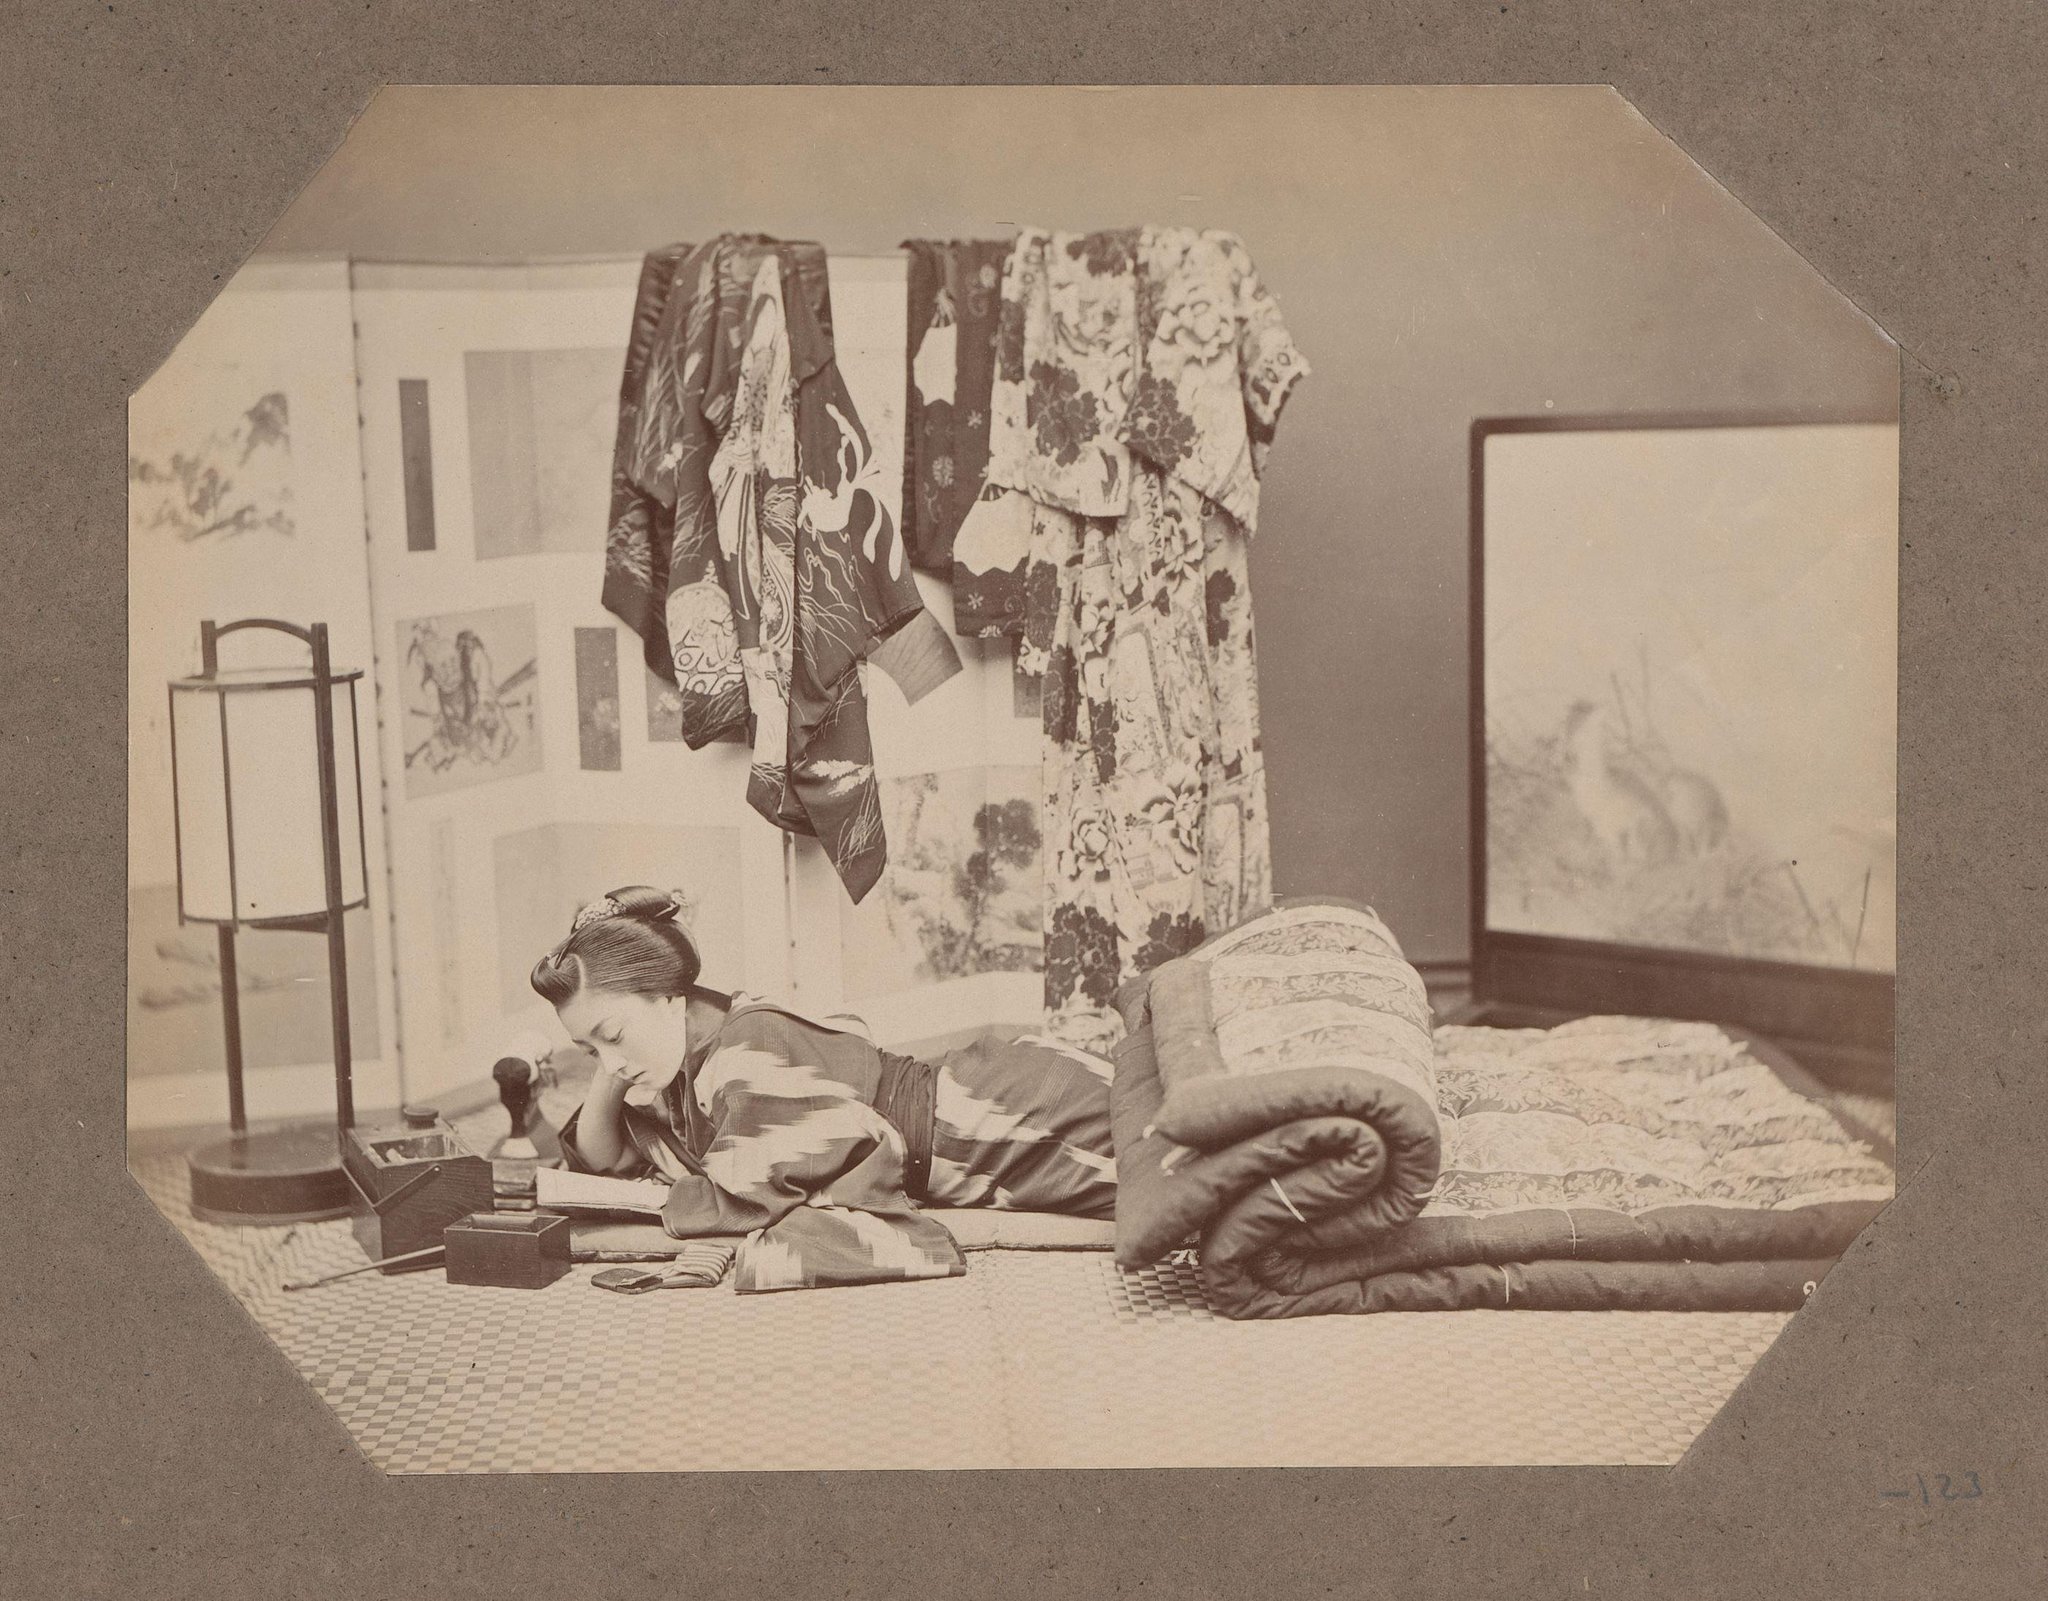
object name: album leaf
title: Interieur met een lezende, liggende vrouw, Japan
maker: Anonymous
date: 1890-1903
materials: paper, photographic support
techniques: albumen print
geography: japan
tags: lying figure - aa - female human figure, other rooms, japan